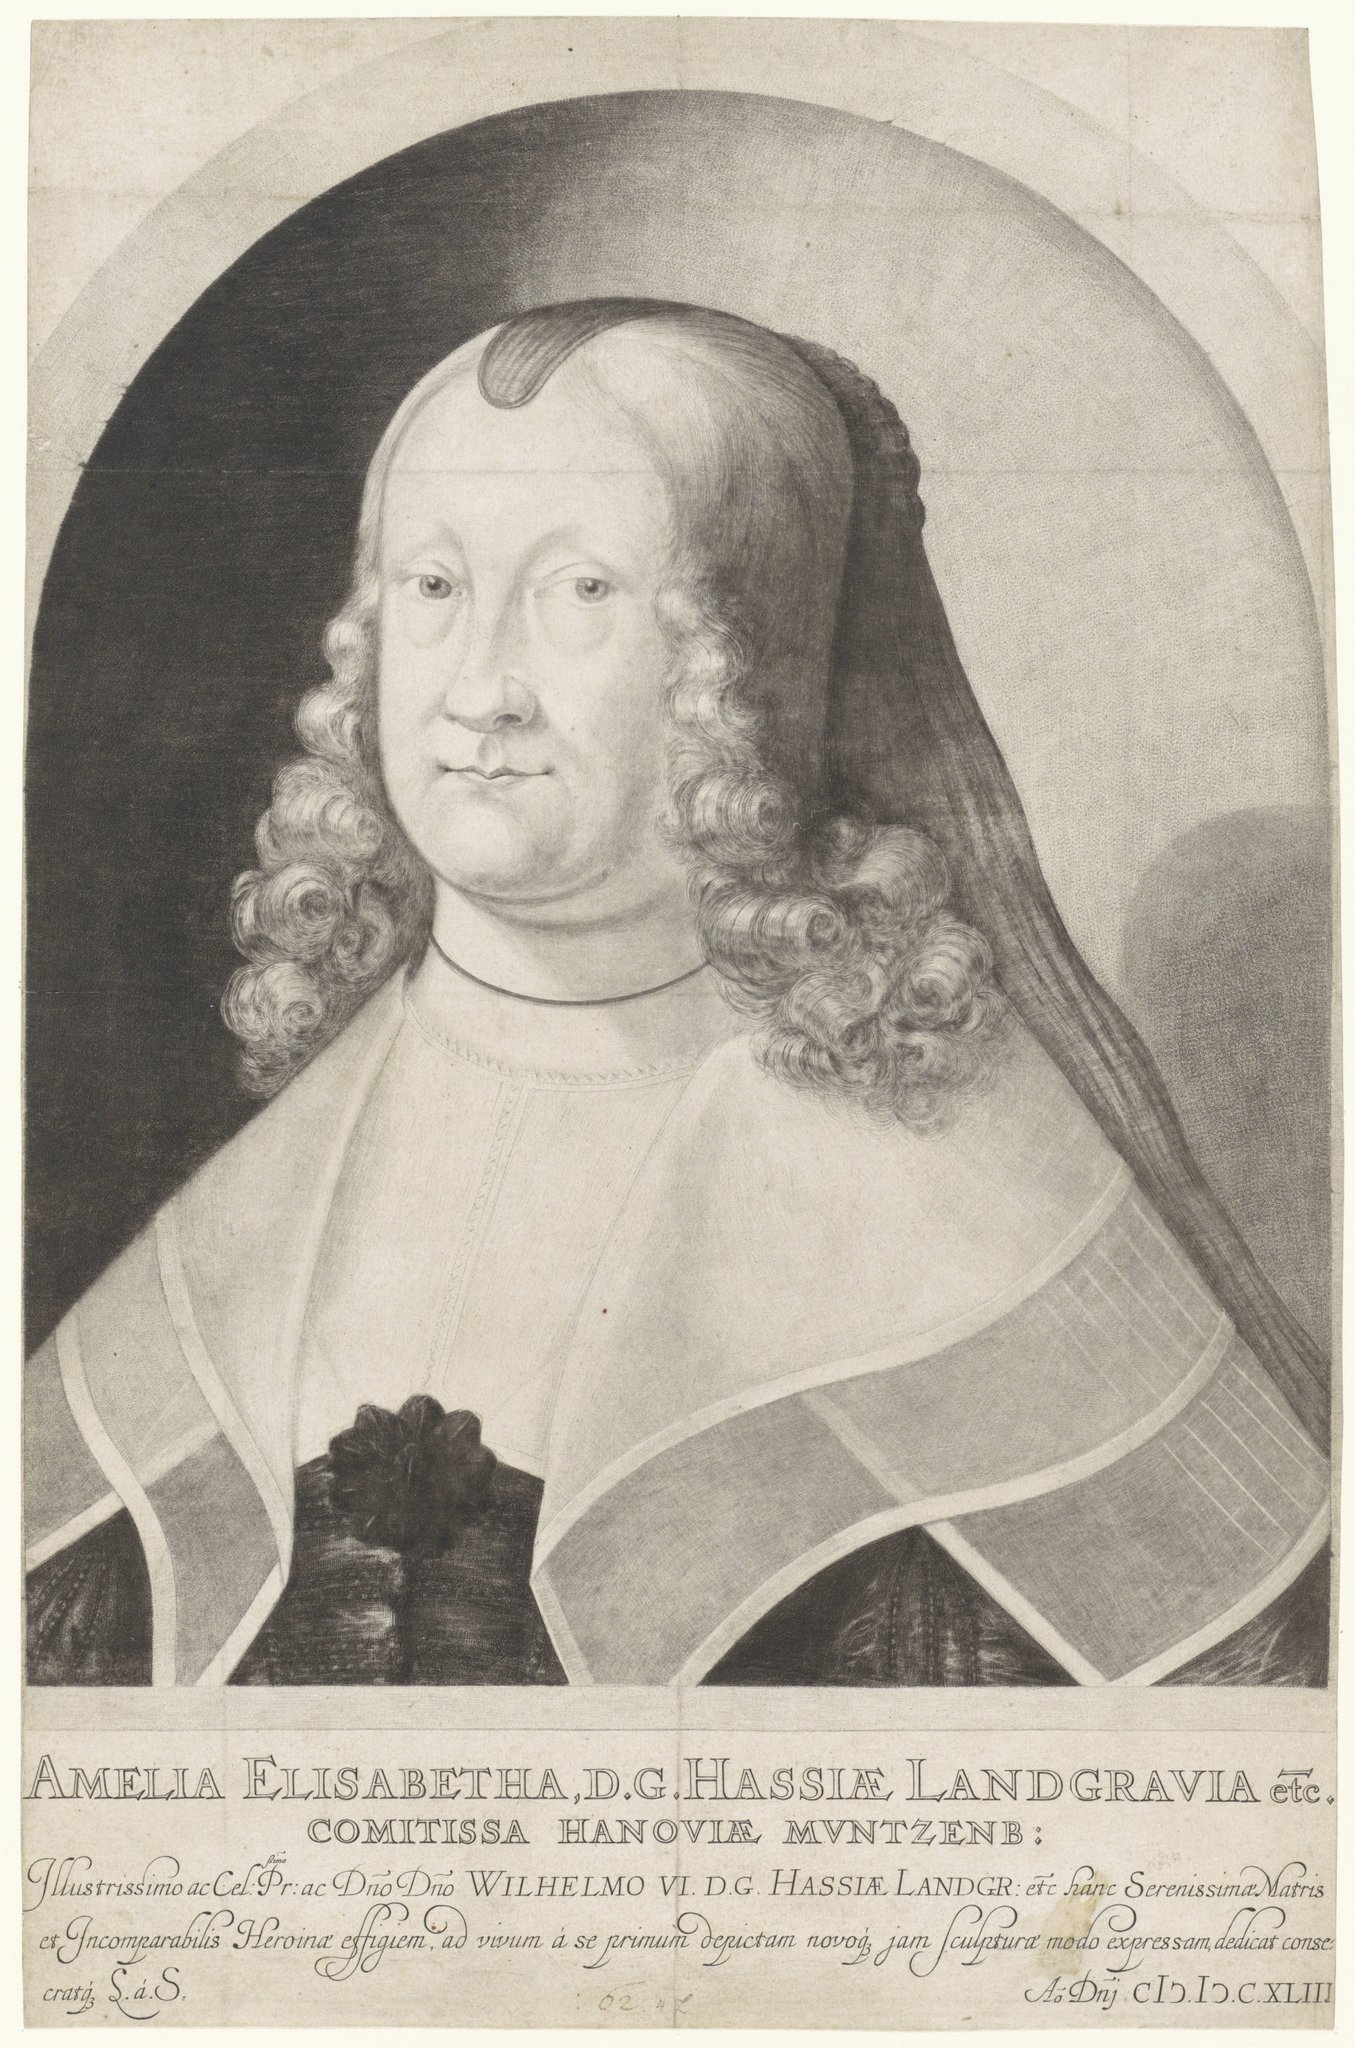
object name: print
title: Portret van Amelia Elisabeth, landgravin van Hessen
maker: ludwig von siegen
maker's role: print maker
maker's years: 1609-1680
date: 1642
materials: paper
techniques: etching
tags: veil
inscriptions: date